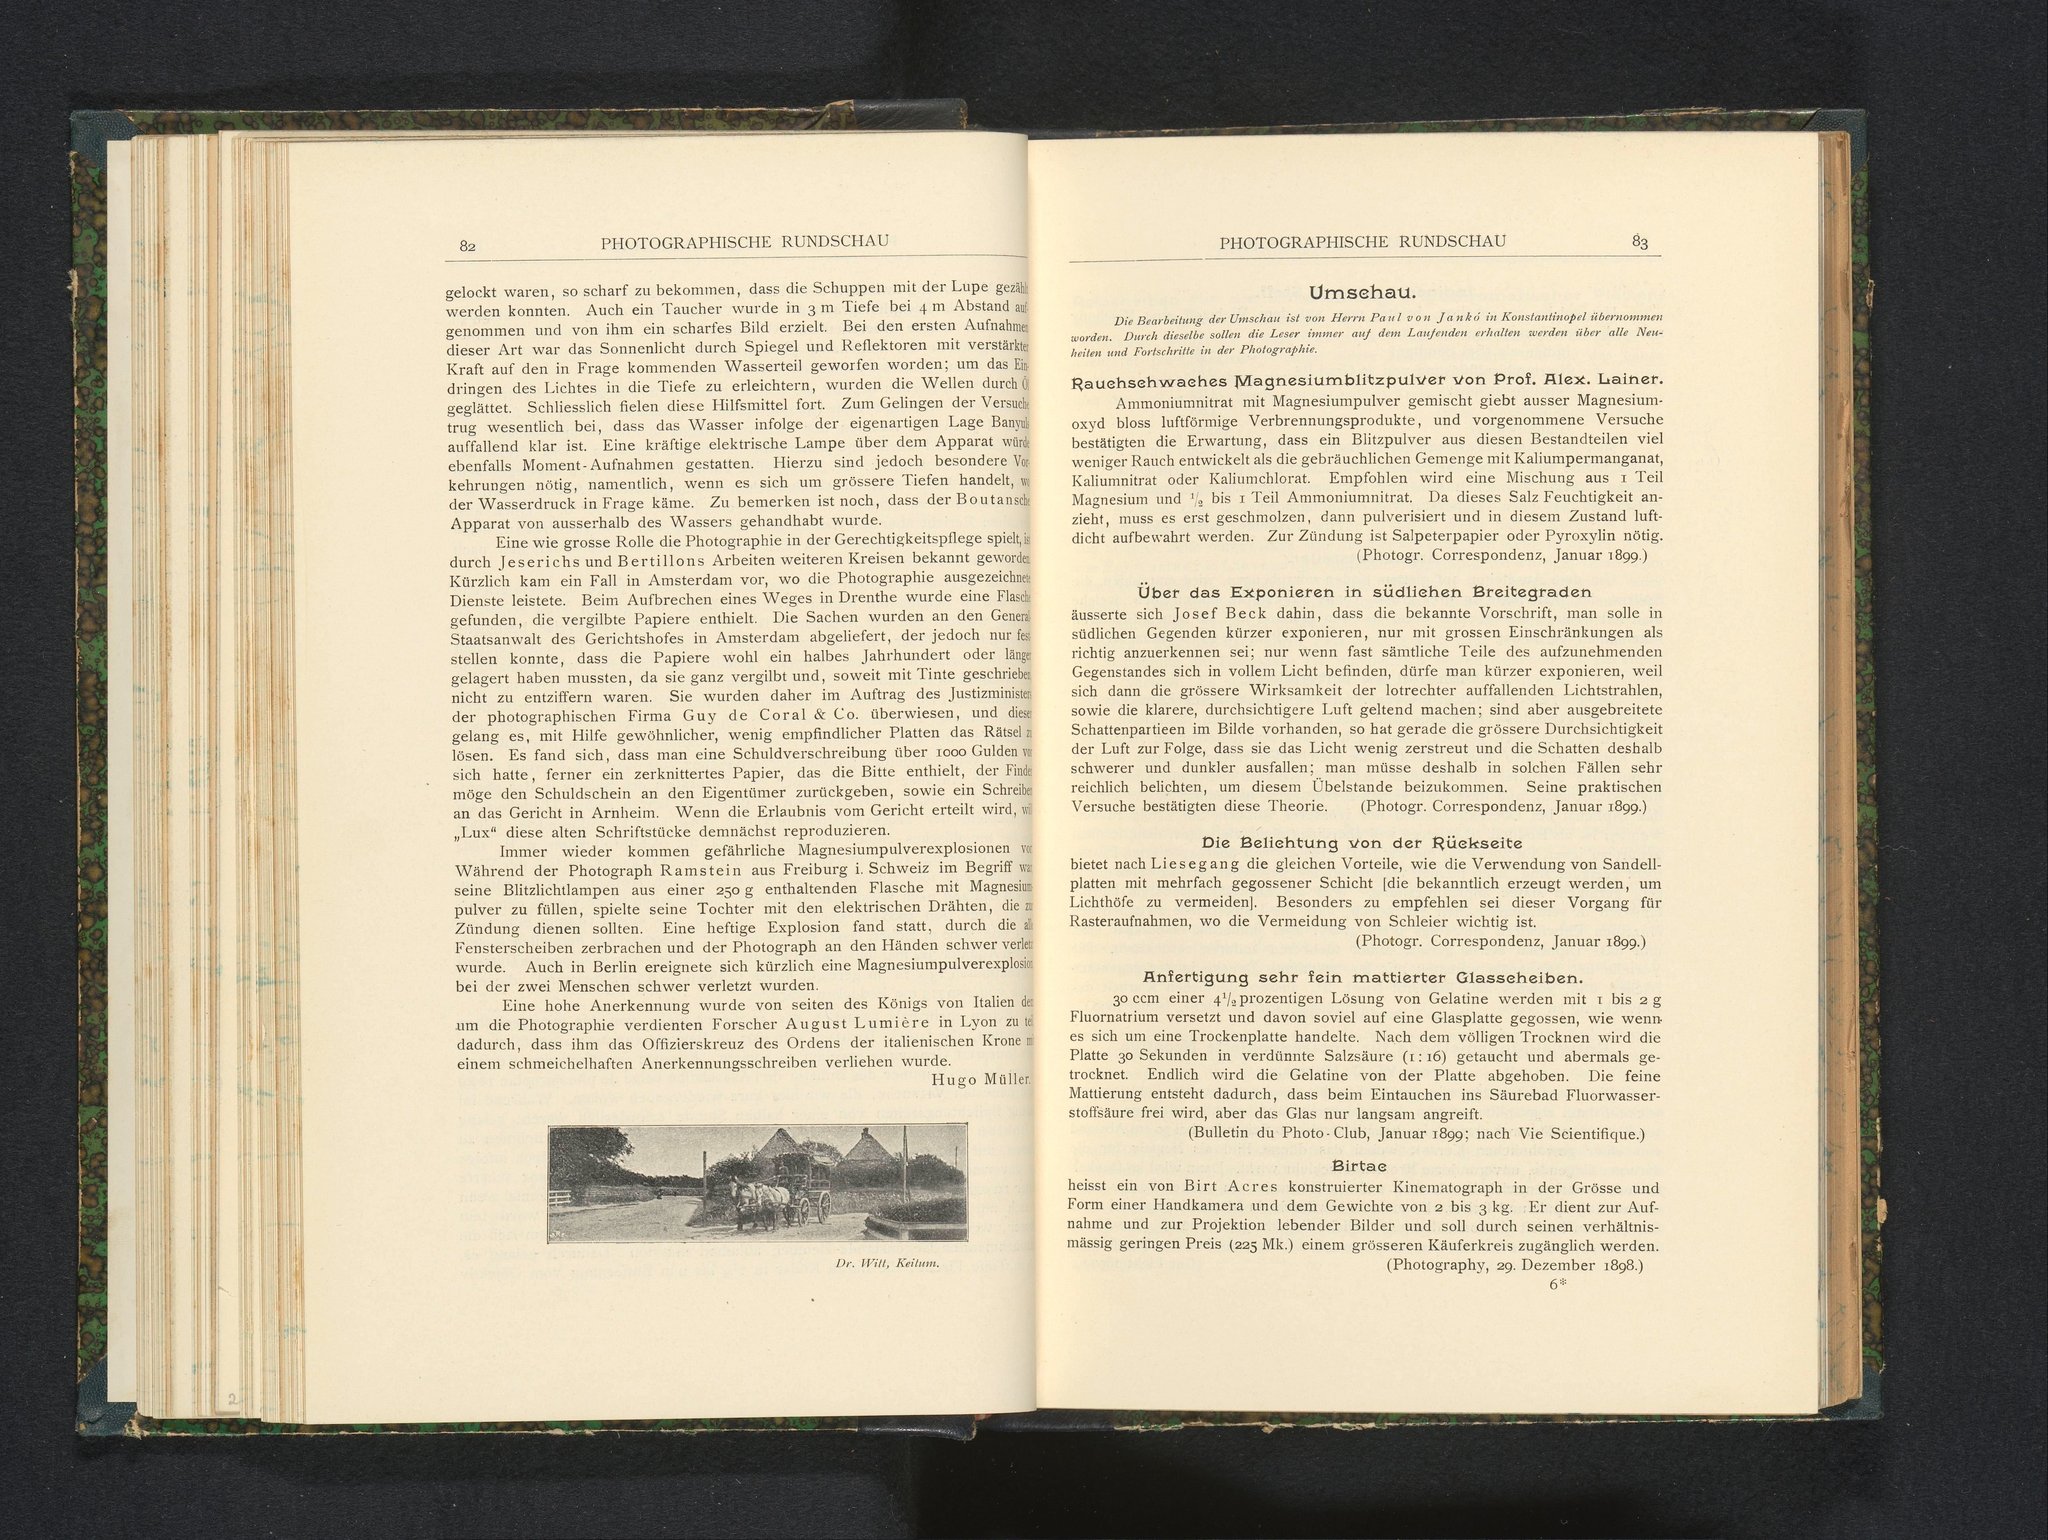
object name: photomechanical print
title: Gezicht op een landweg met paard en wagen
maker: dr. witt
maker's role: fotograaf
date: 1894-1899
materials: paper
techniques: autotype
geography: berlin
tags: road, path, horse